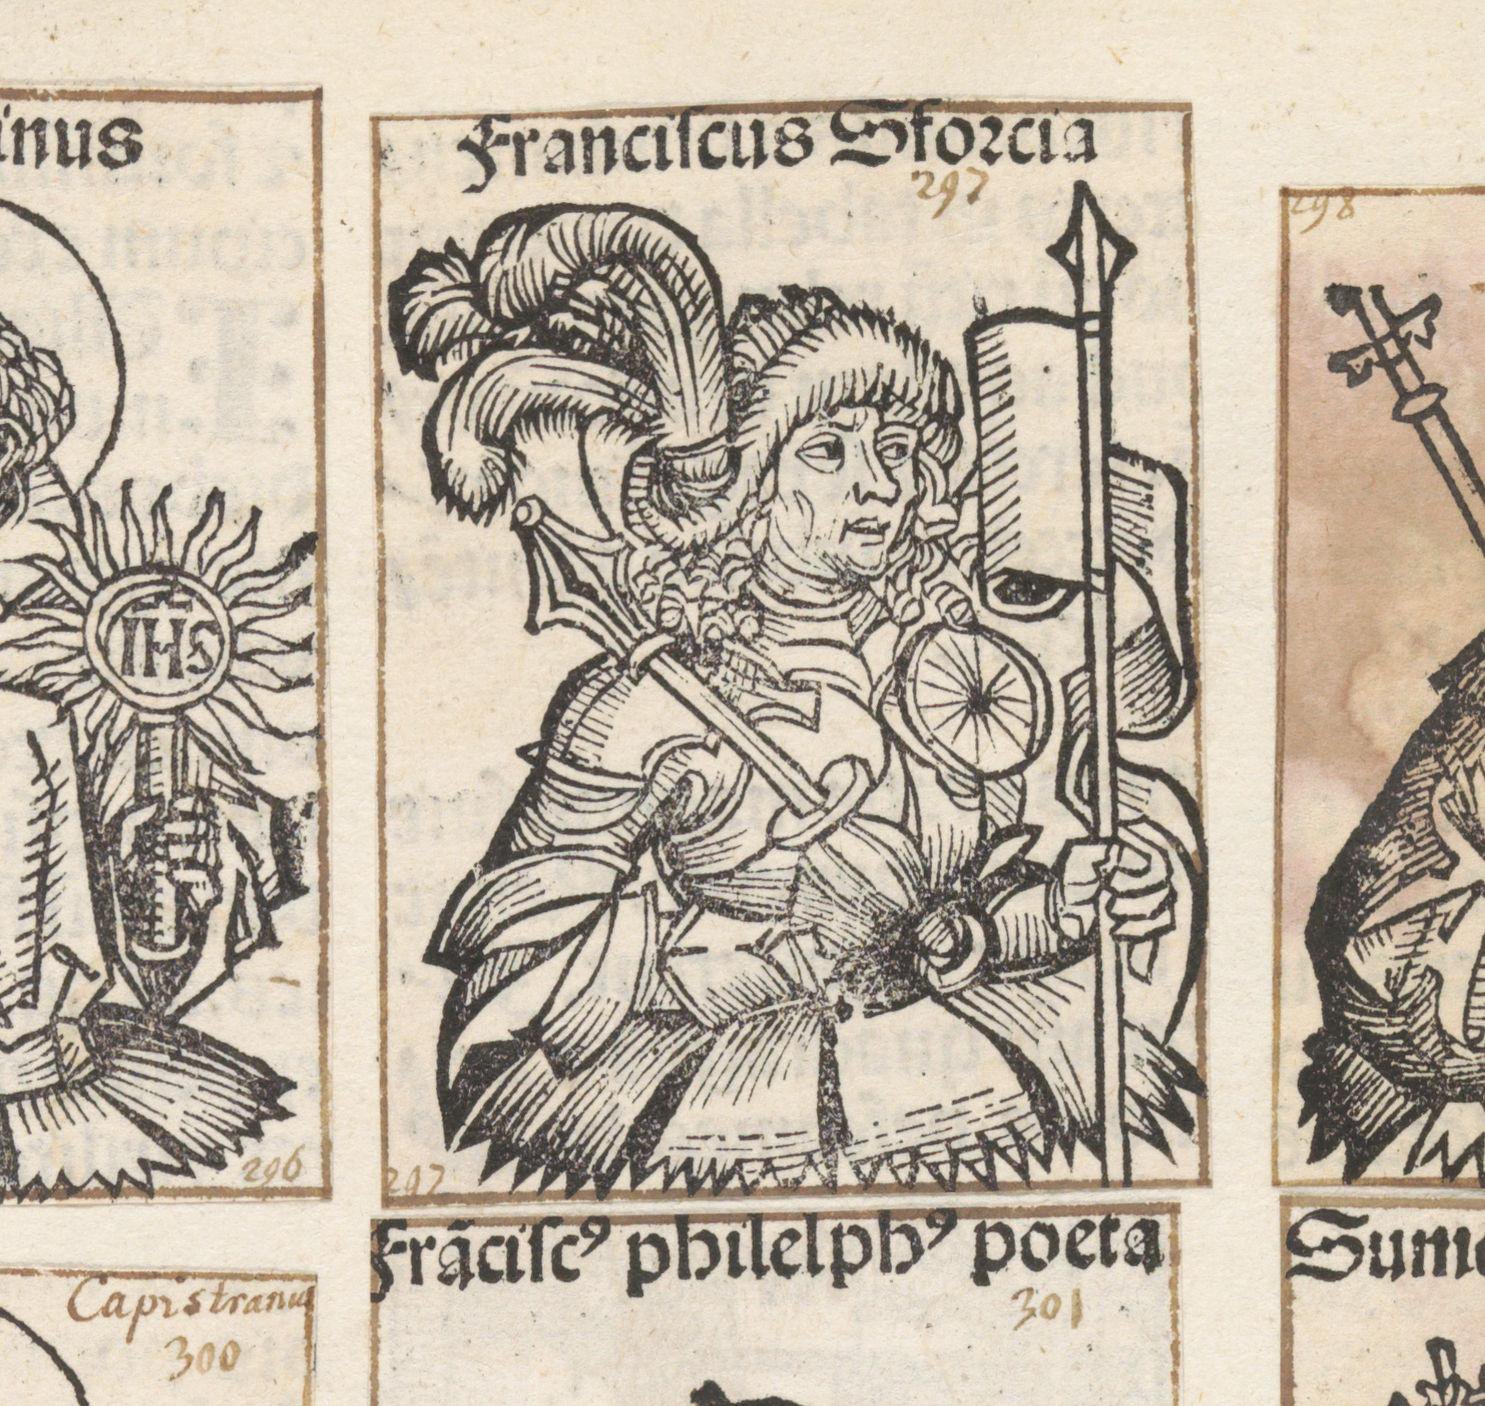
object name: book illustration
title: Francesco Sforza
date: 1493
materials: paper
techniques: letterpress printing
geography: nuremberg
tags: standard-bearer, flag-bearer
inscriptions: inscription: ‘297’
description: De houtsnede wordt herhaaldelijk gebruikt als boekillustratie in de Liber Chronicarum (of Neurenbergkroniek) van Hartmann Schedel, verschenen in het Latijn en Duits in 1493. Zie de Latijnse uitgave, folio 248v.